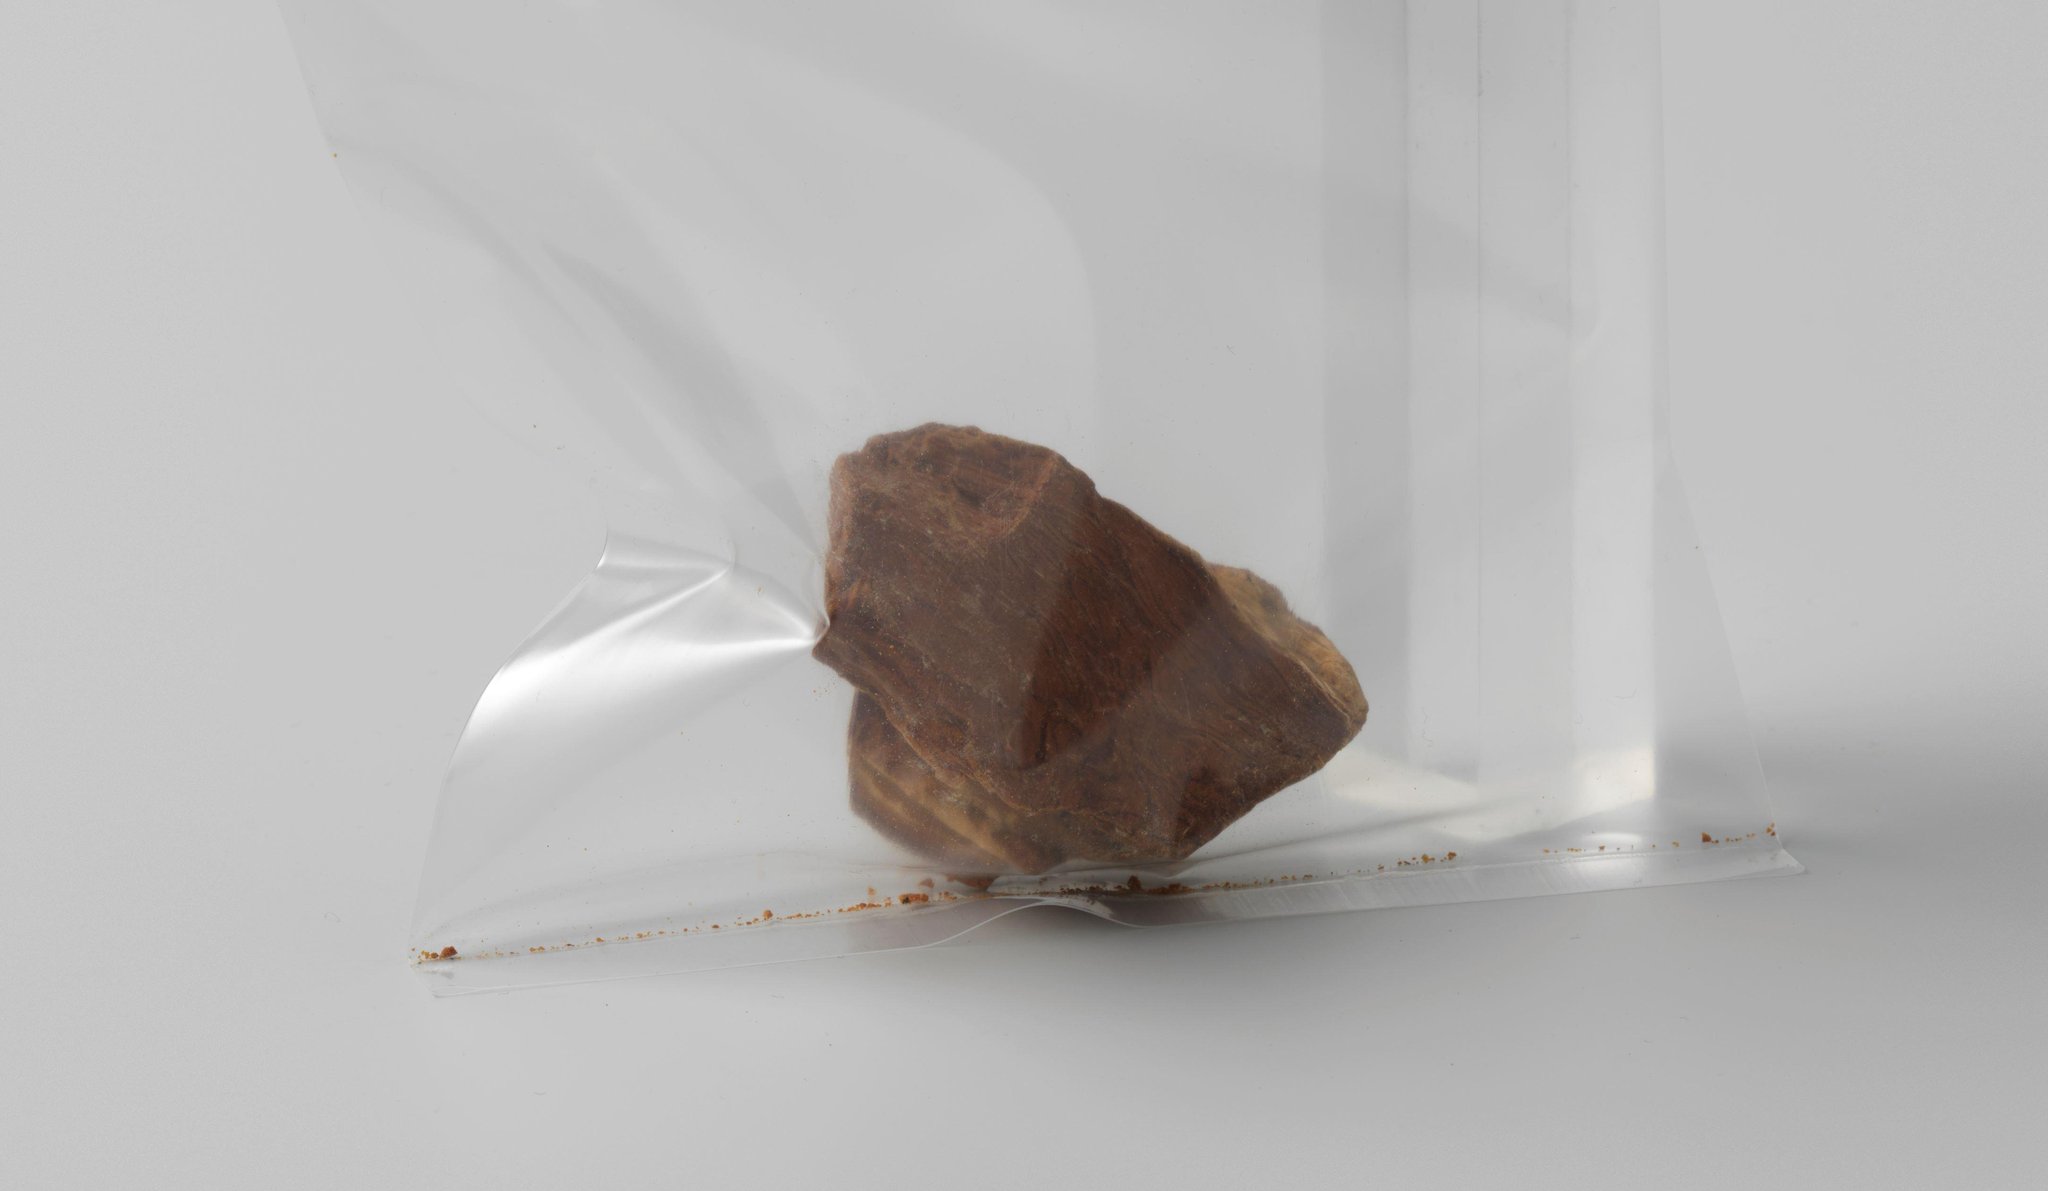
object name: artifact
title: Brok uit V.O.C.-schip de 'Witte Leeuw'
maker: Anonymous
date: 1613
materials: pigment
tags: verenigde oostindische compagnie, sint-helena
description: Brok uit V.O.C.-schip de 'Witte Leeuw', loodwit, grondstof voor verf.